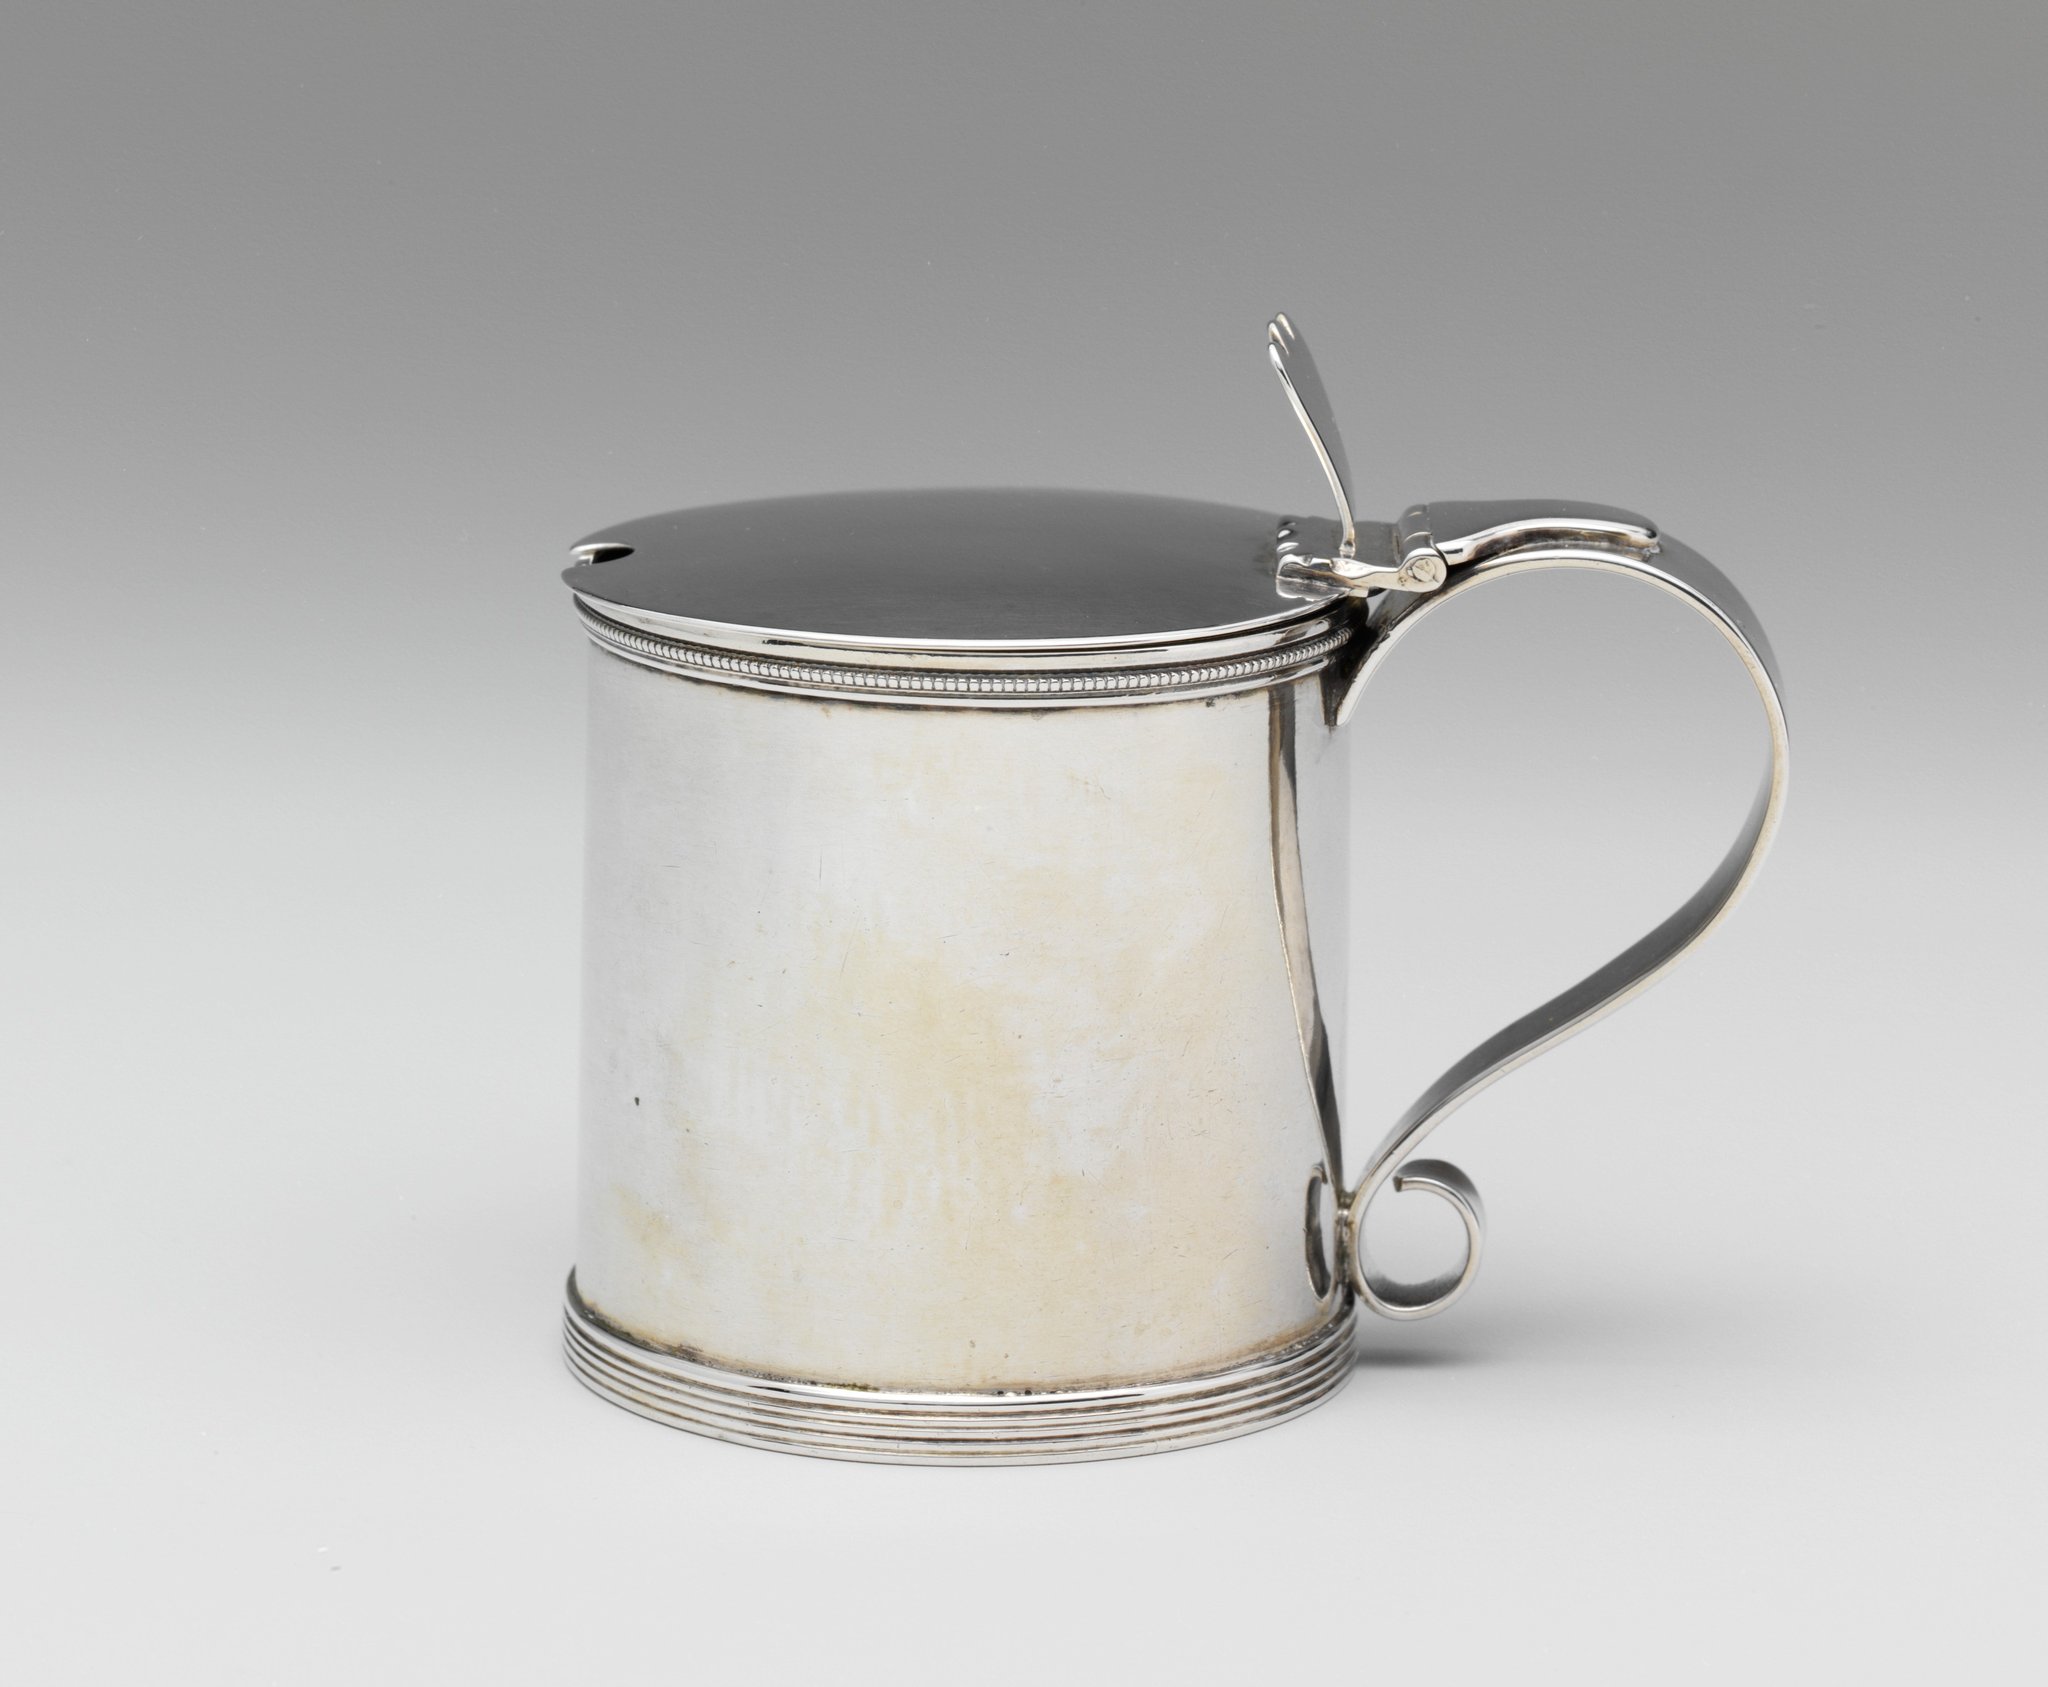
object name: mustard pot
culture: american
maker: joseph shoemaker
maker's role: maker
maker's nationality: american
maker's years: 1765-1829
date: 1795-1820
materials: silver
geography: united states